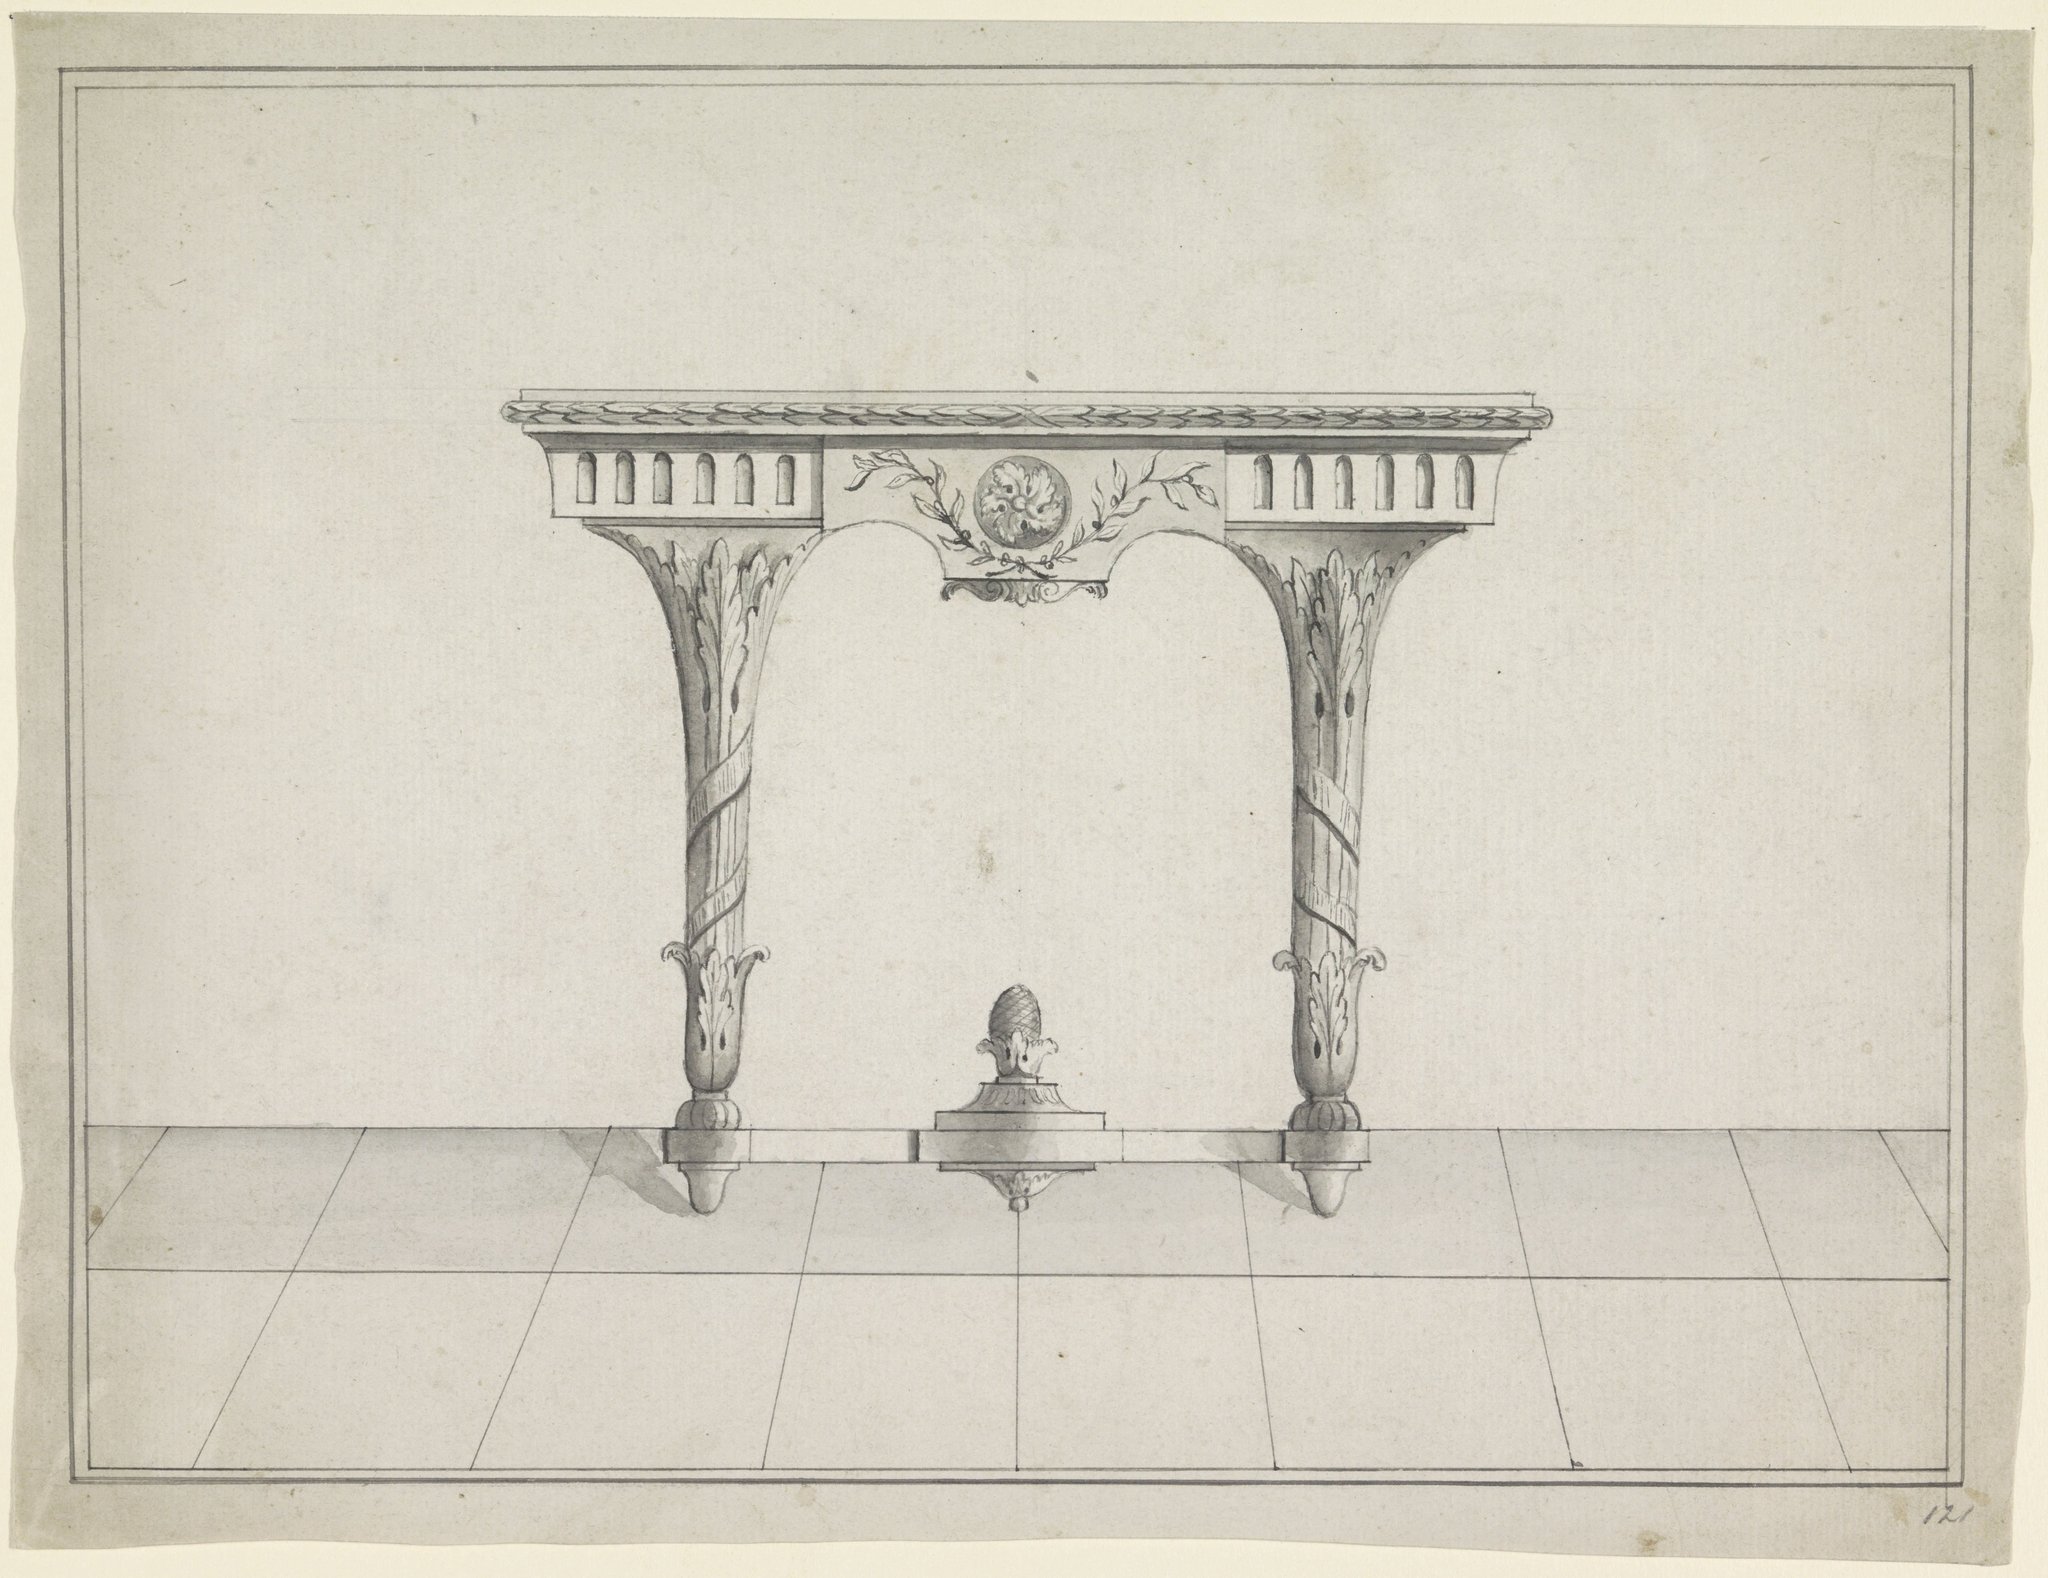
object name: drawing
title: Wandtafel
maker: Anonymous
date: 1775-1800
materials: ink, paper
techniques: brush, pen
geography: netherlands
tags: table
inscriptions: collector's mark: Lugt 2228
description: Een geornamenteerde wandtafel met acanthusmotieven, een dennenappel en een rozet.